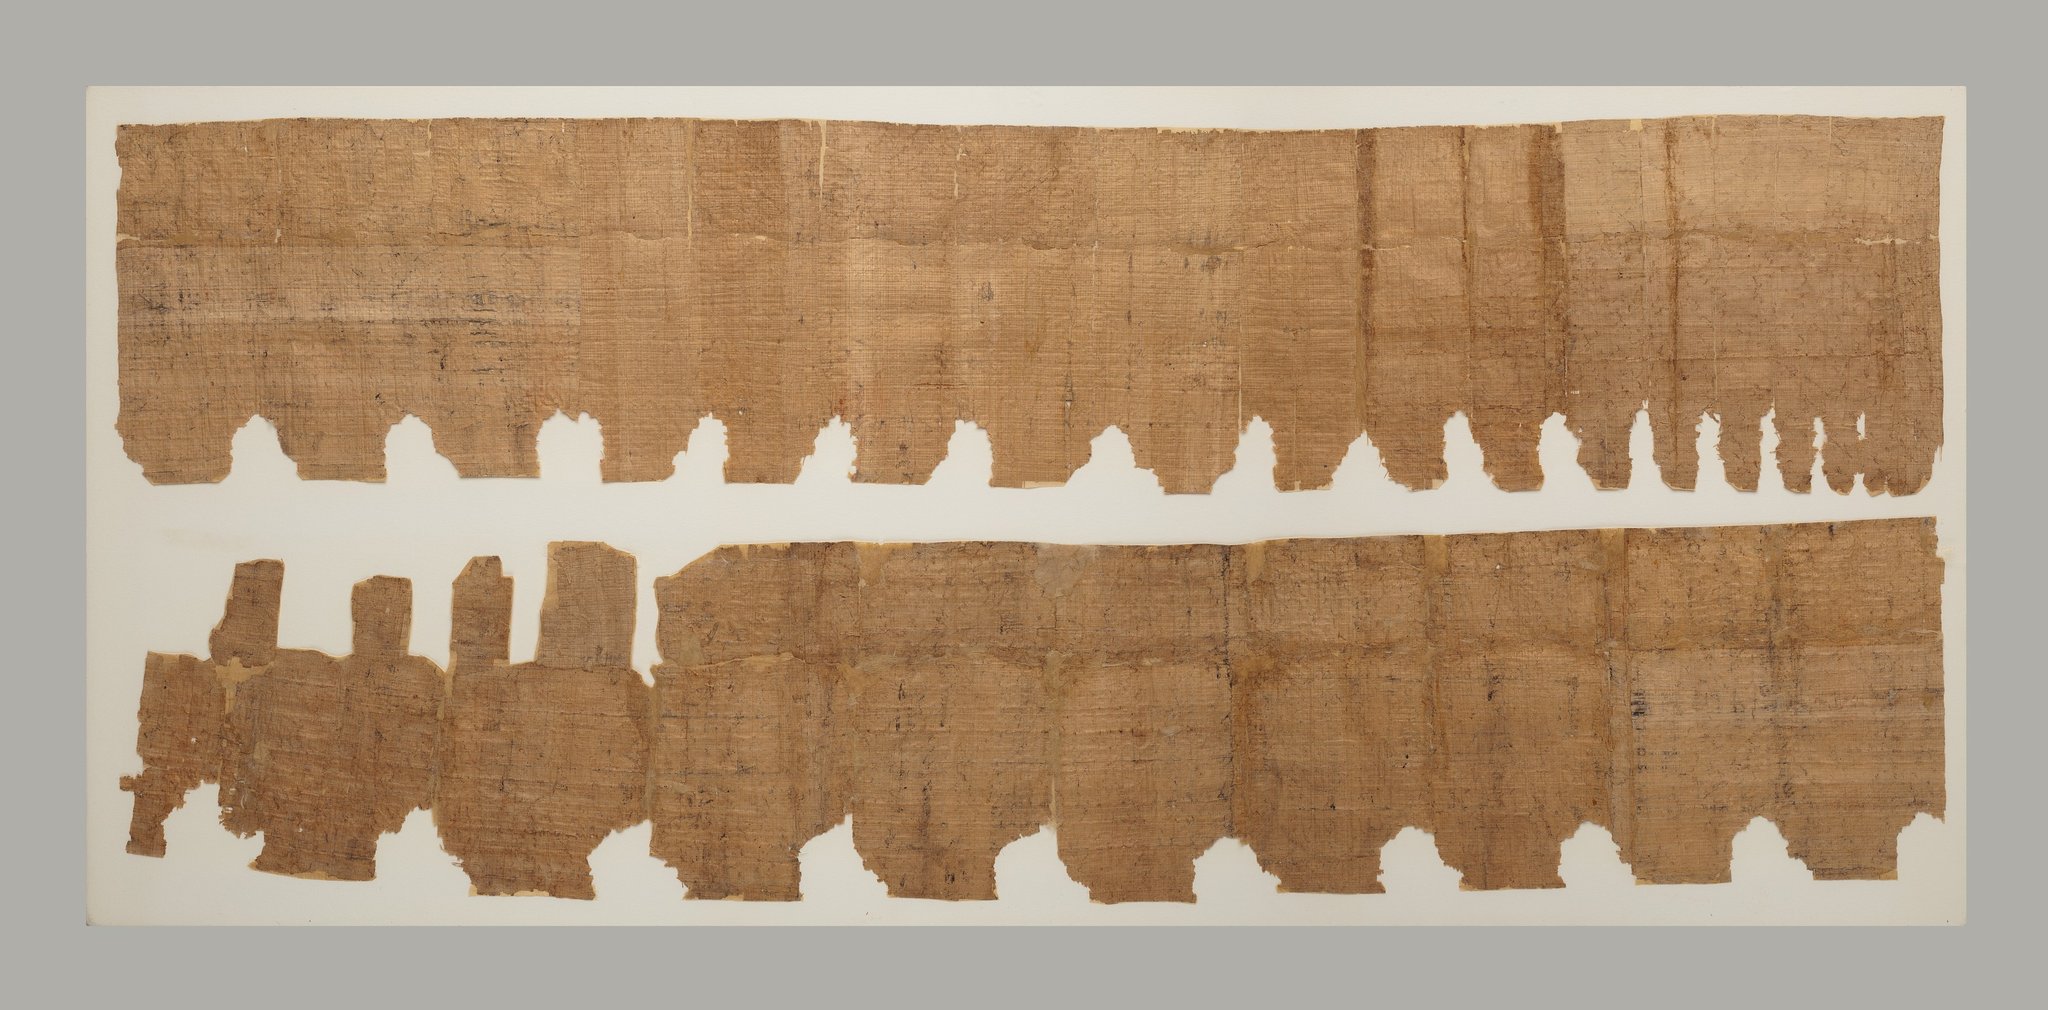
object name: papyrus, blank, washed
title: Blank sheet of papyrus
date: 2051-1981 BCE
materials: ink, papyrus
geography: egypt